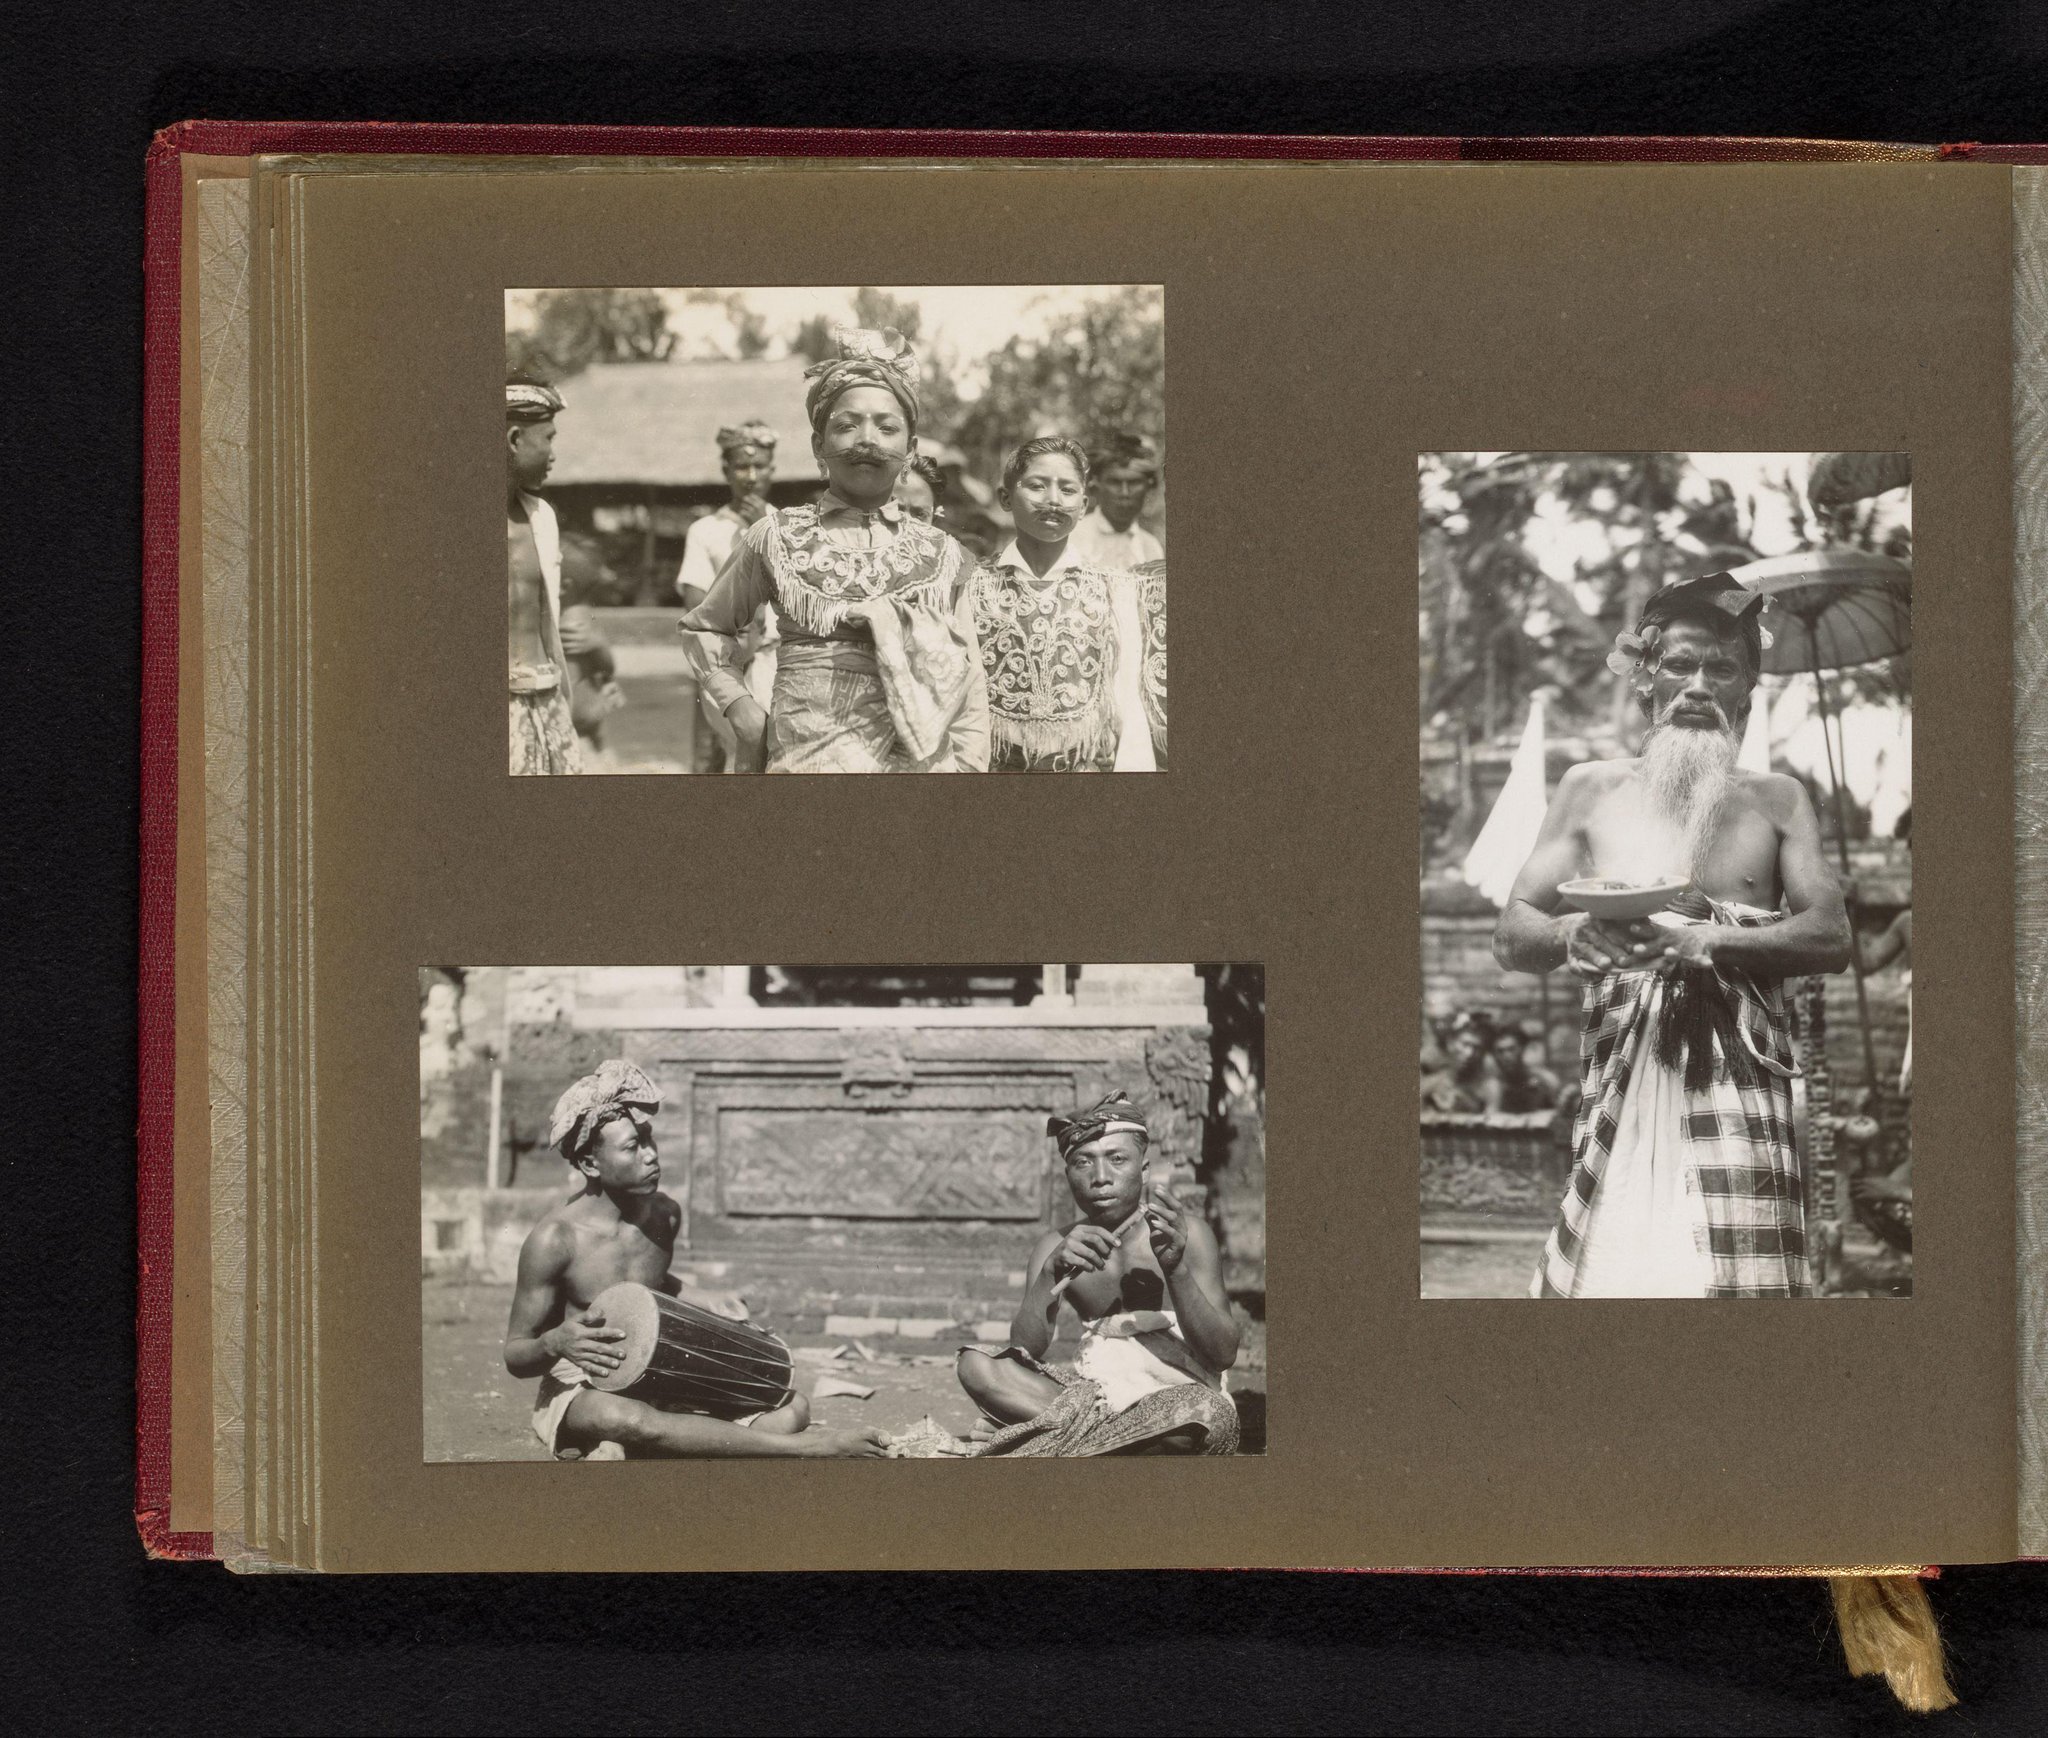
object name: photograph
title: Jongens met nep-snorren, Twee mannen waarvan één met trommel en Oude man met een schaal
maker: Anonymous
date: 1950-1960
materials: photographic support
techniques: gelatin silver print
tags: adult man, historical persons, drum (musical instrument), old man, kneeling on both knees, dutch east indies, the